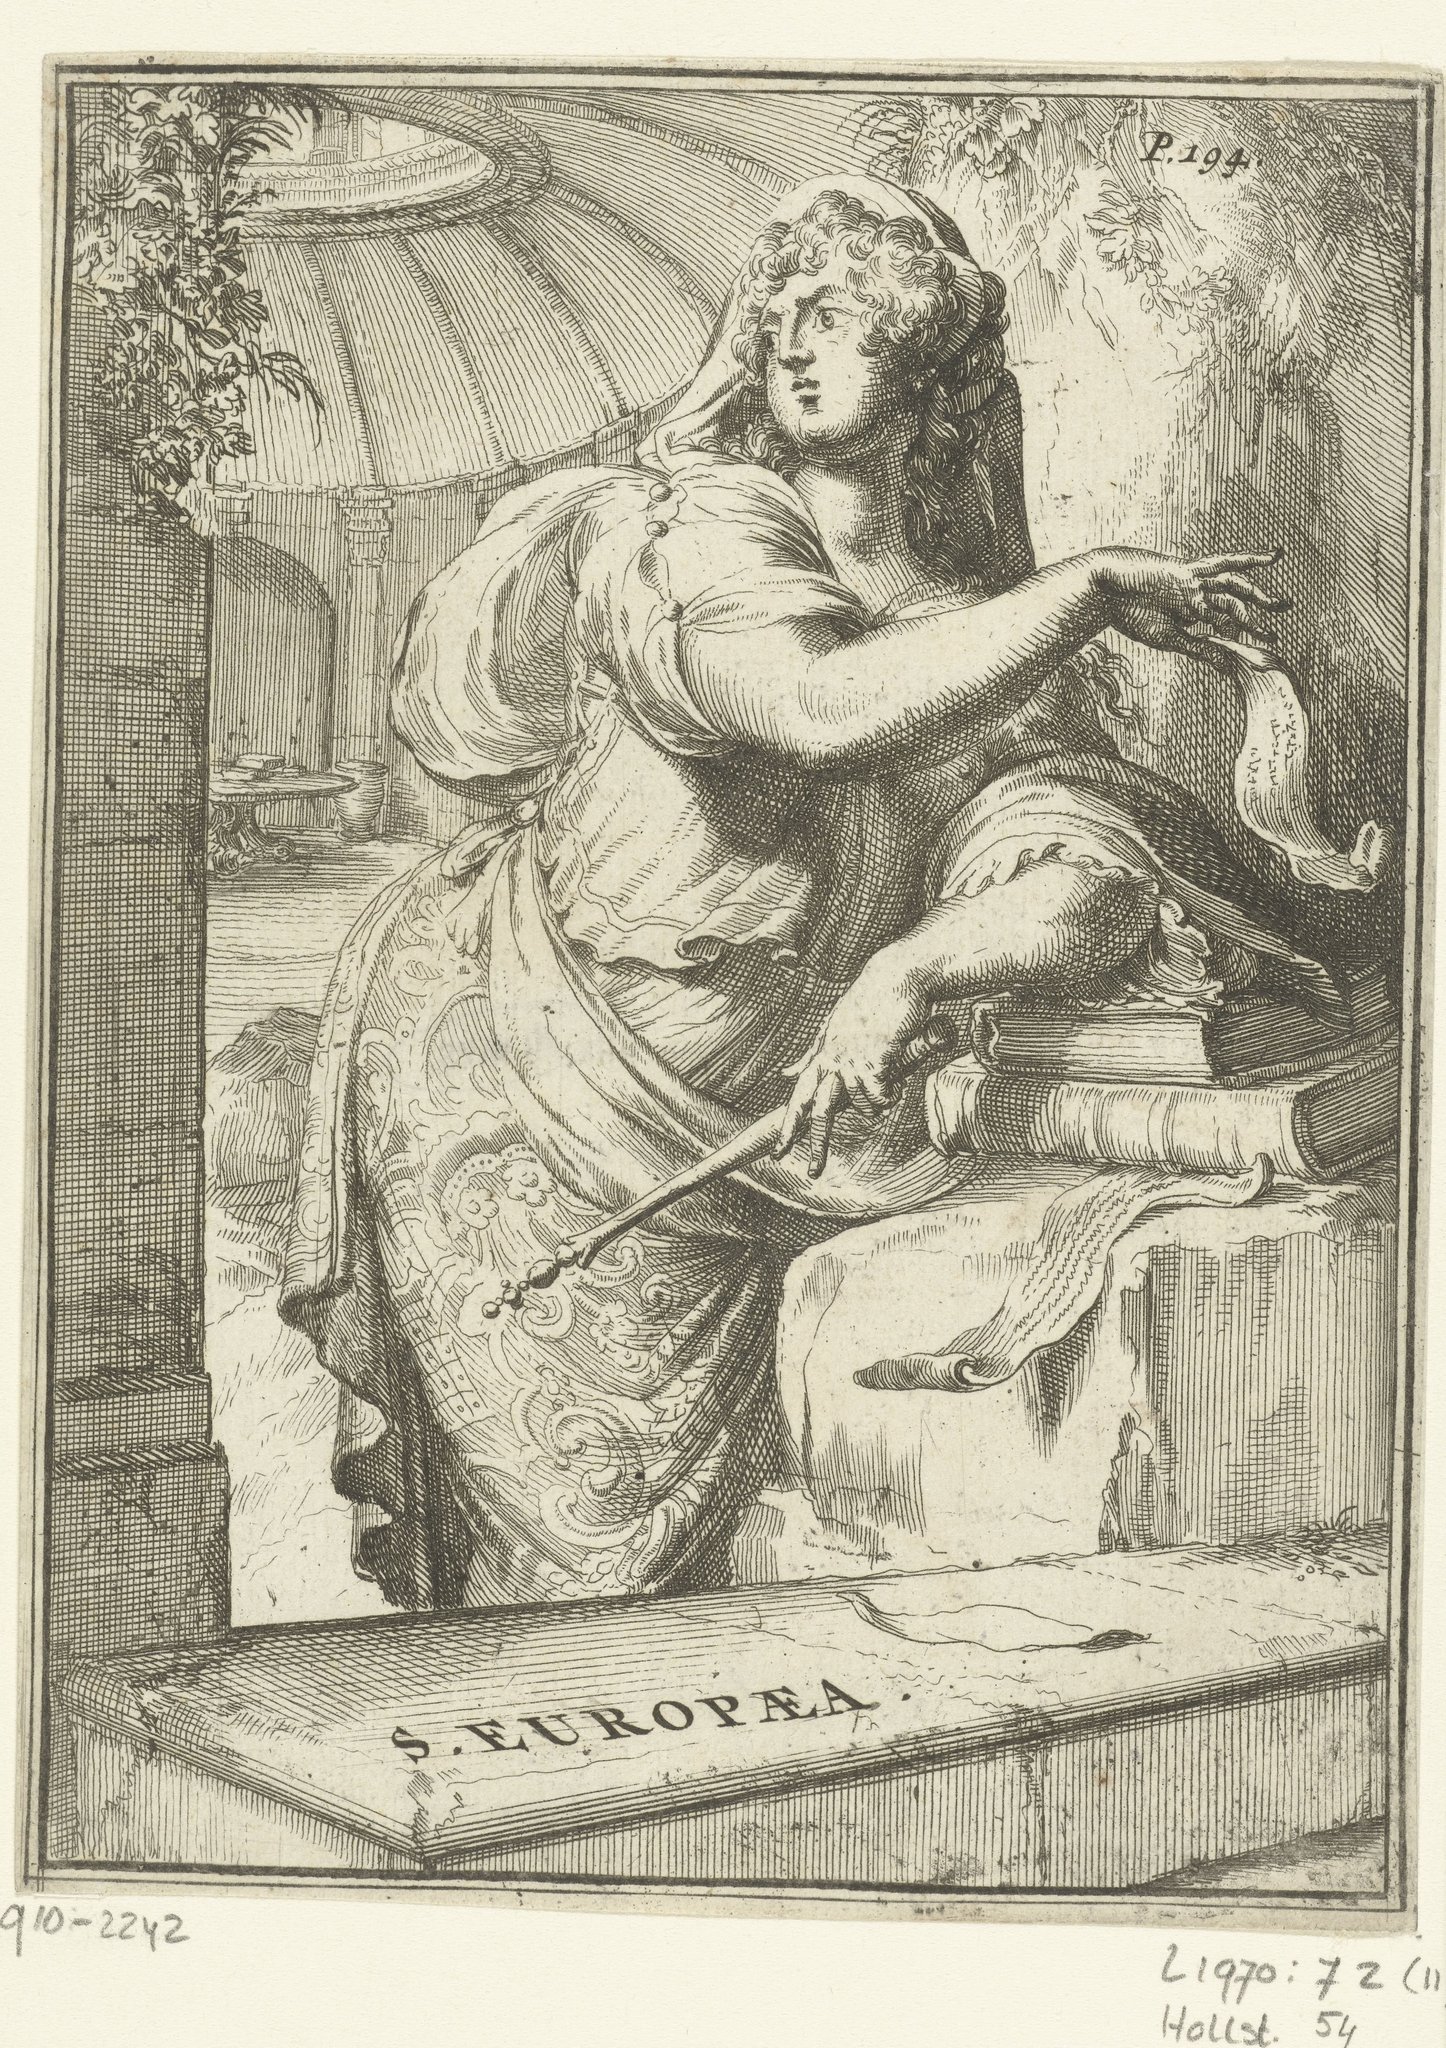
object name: print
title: Europese sibille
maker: romeyn de hooghe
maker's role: draughtsman, goldsmith, painter, print maker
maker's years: 1645-1708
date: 1688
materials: paper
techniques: engraving, etching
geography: netherlands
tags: sibyls (with name)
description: Illustratie voor: Servatius Gallaeus, Dissertationes de Sibyllis, earumque oraculis, Amsterdam, Dirk en Hendrik Boom, 1688, p. 194.